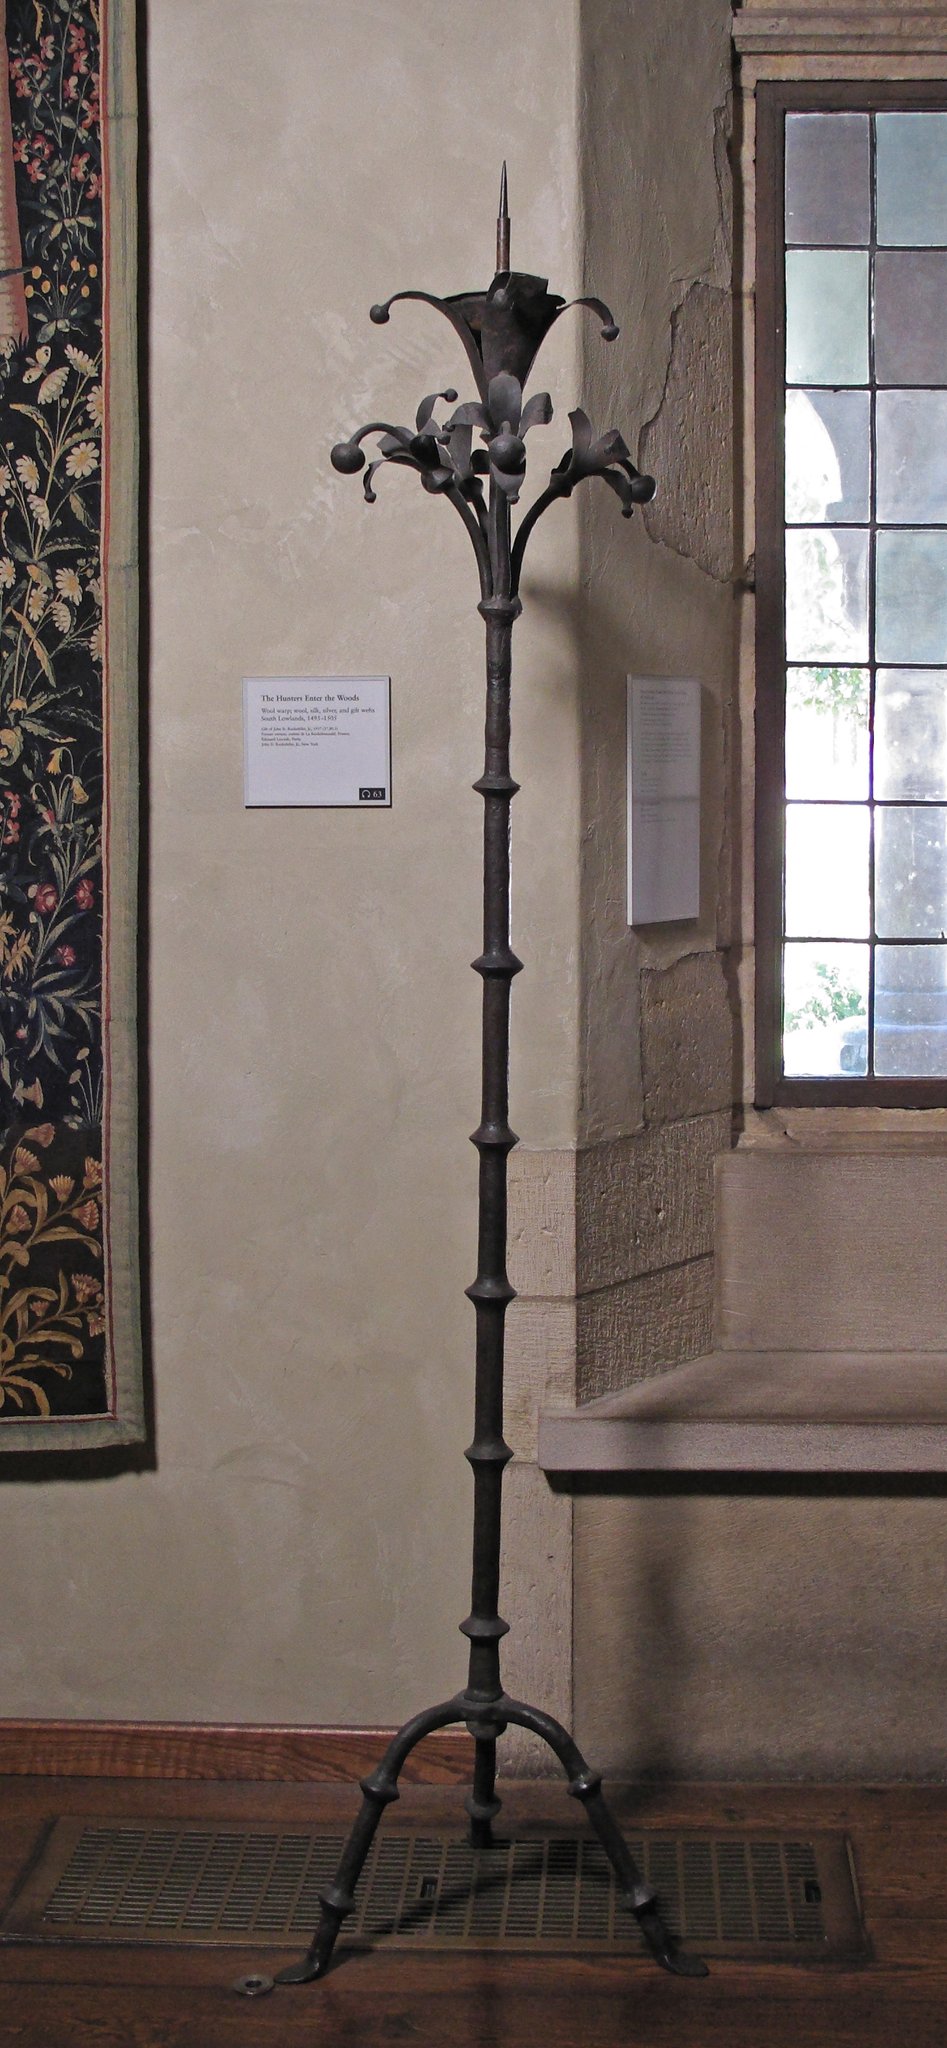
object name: candelabrum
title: Candelabra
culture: spanish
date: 1301-1400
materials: iron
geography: spain